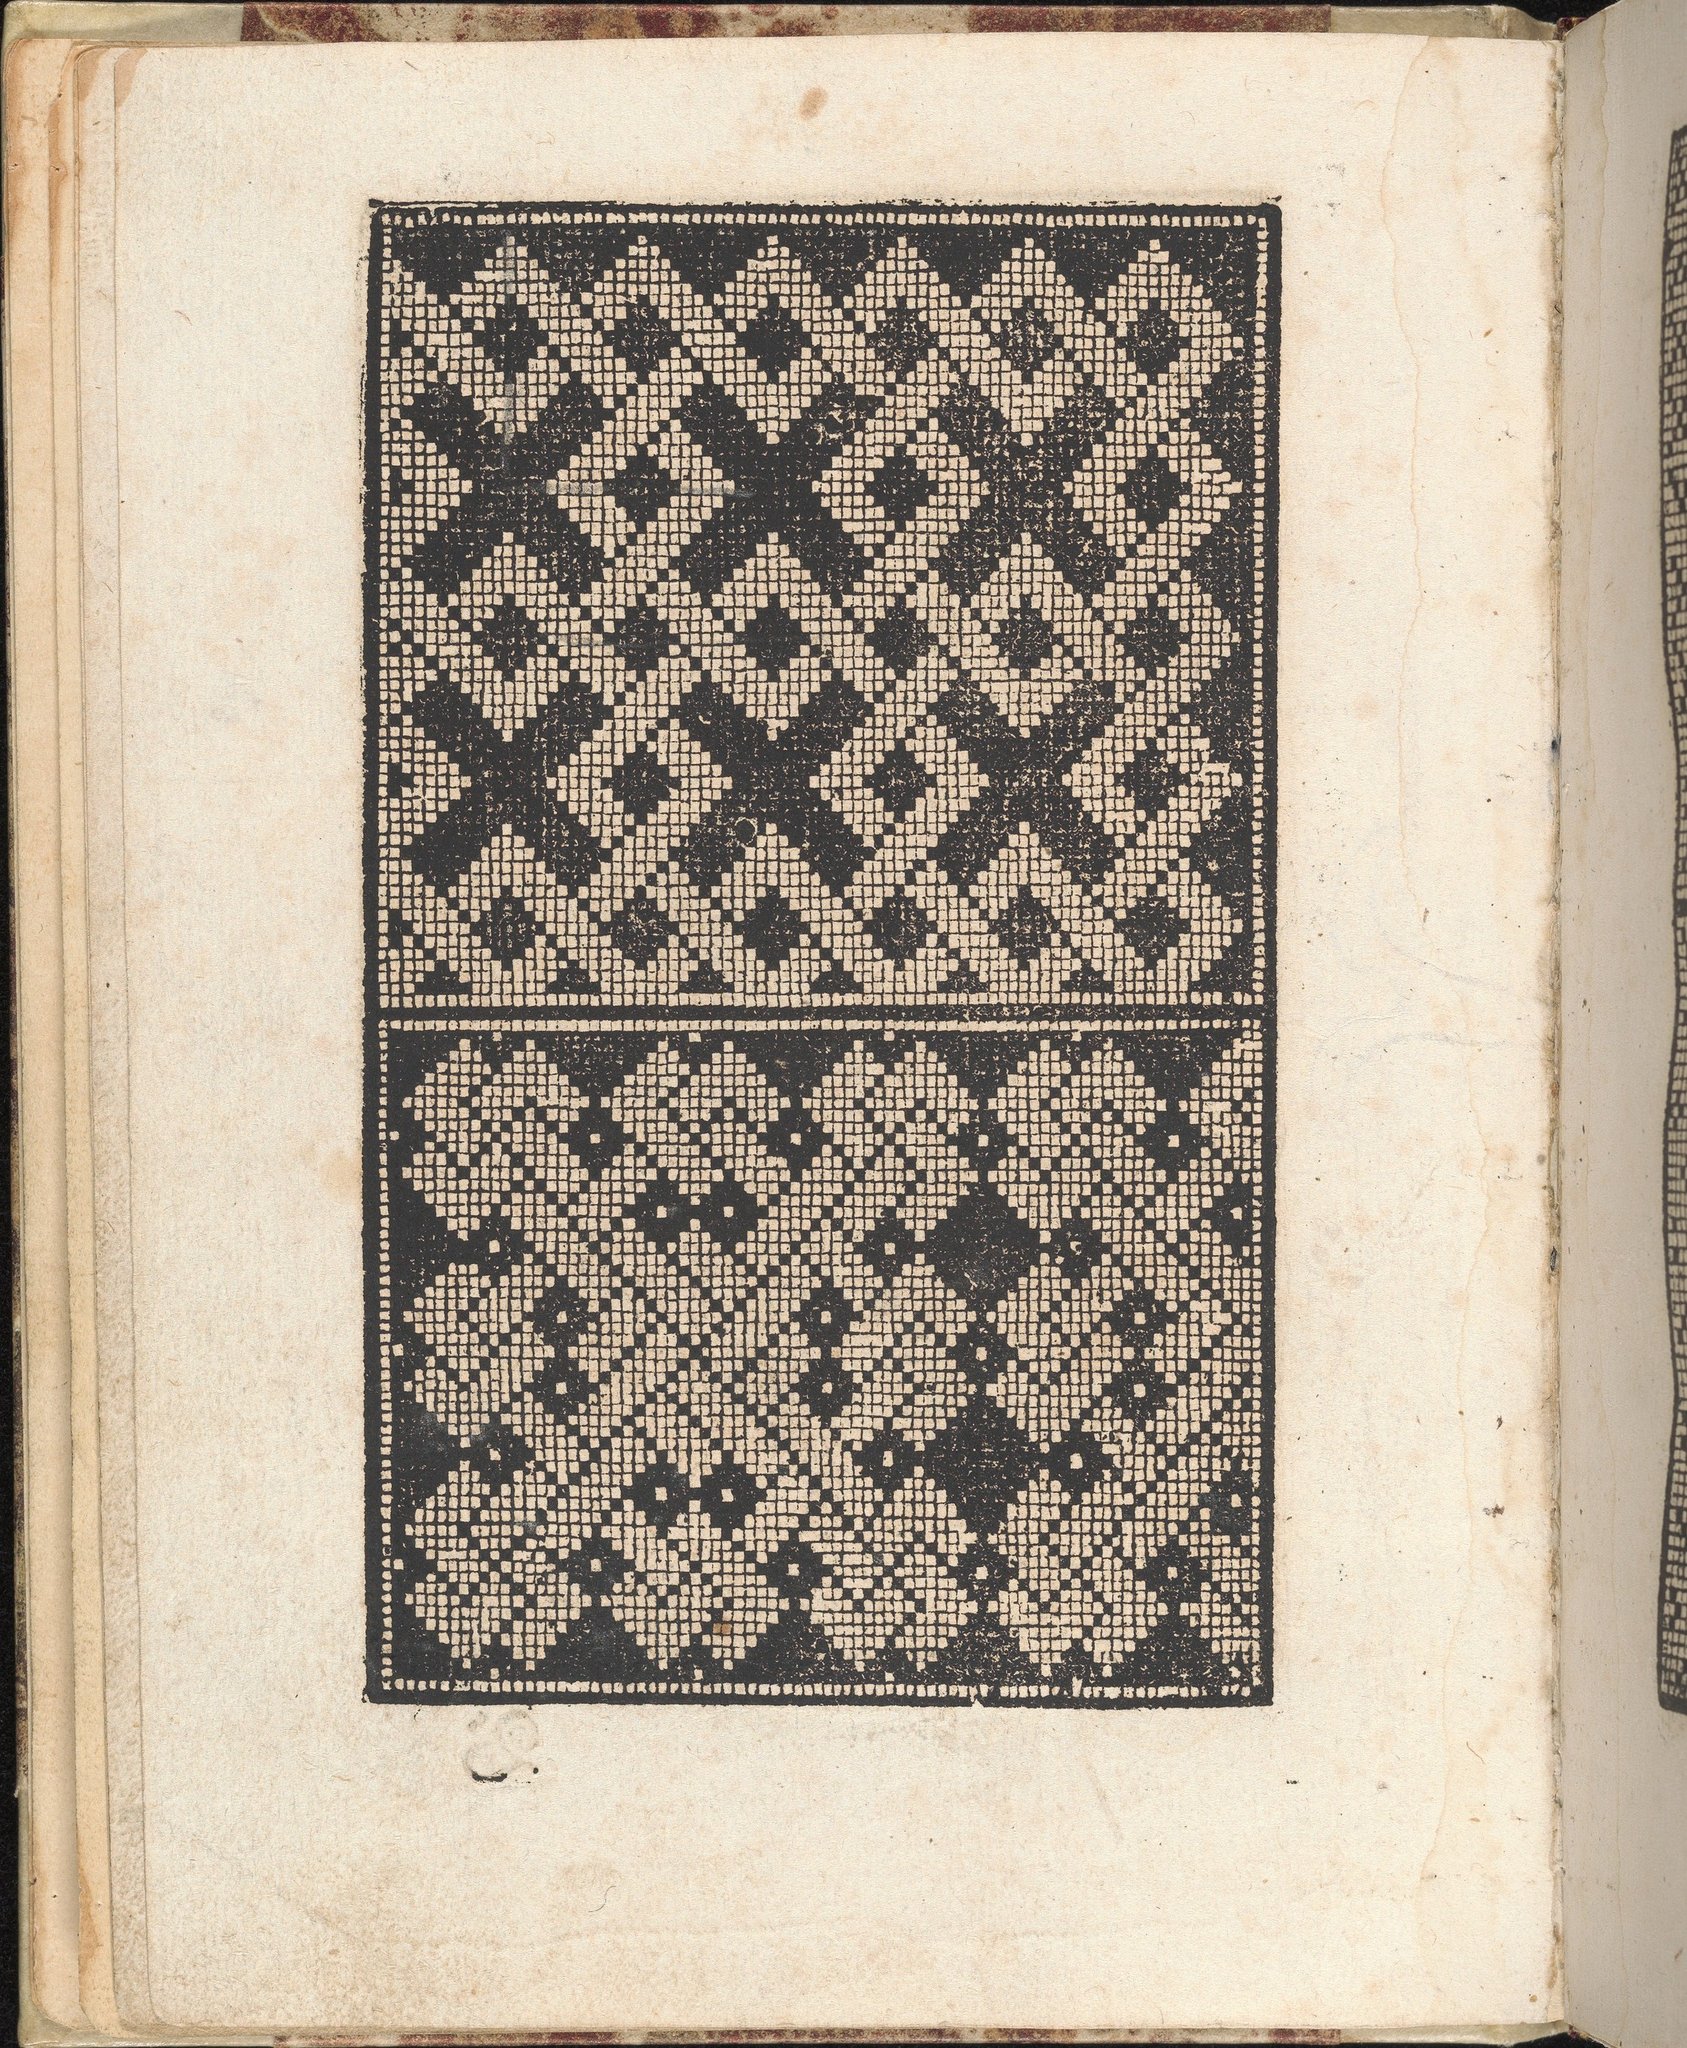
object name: book print ornament architecture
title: Ein new getruckt model Büchli...Page 6, recto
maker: johann schönsperger the younger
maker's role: publisher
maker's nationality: german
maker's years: 1490-1550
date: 1529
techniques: woodcut